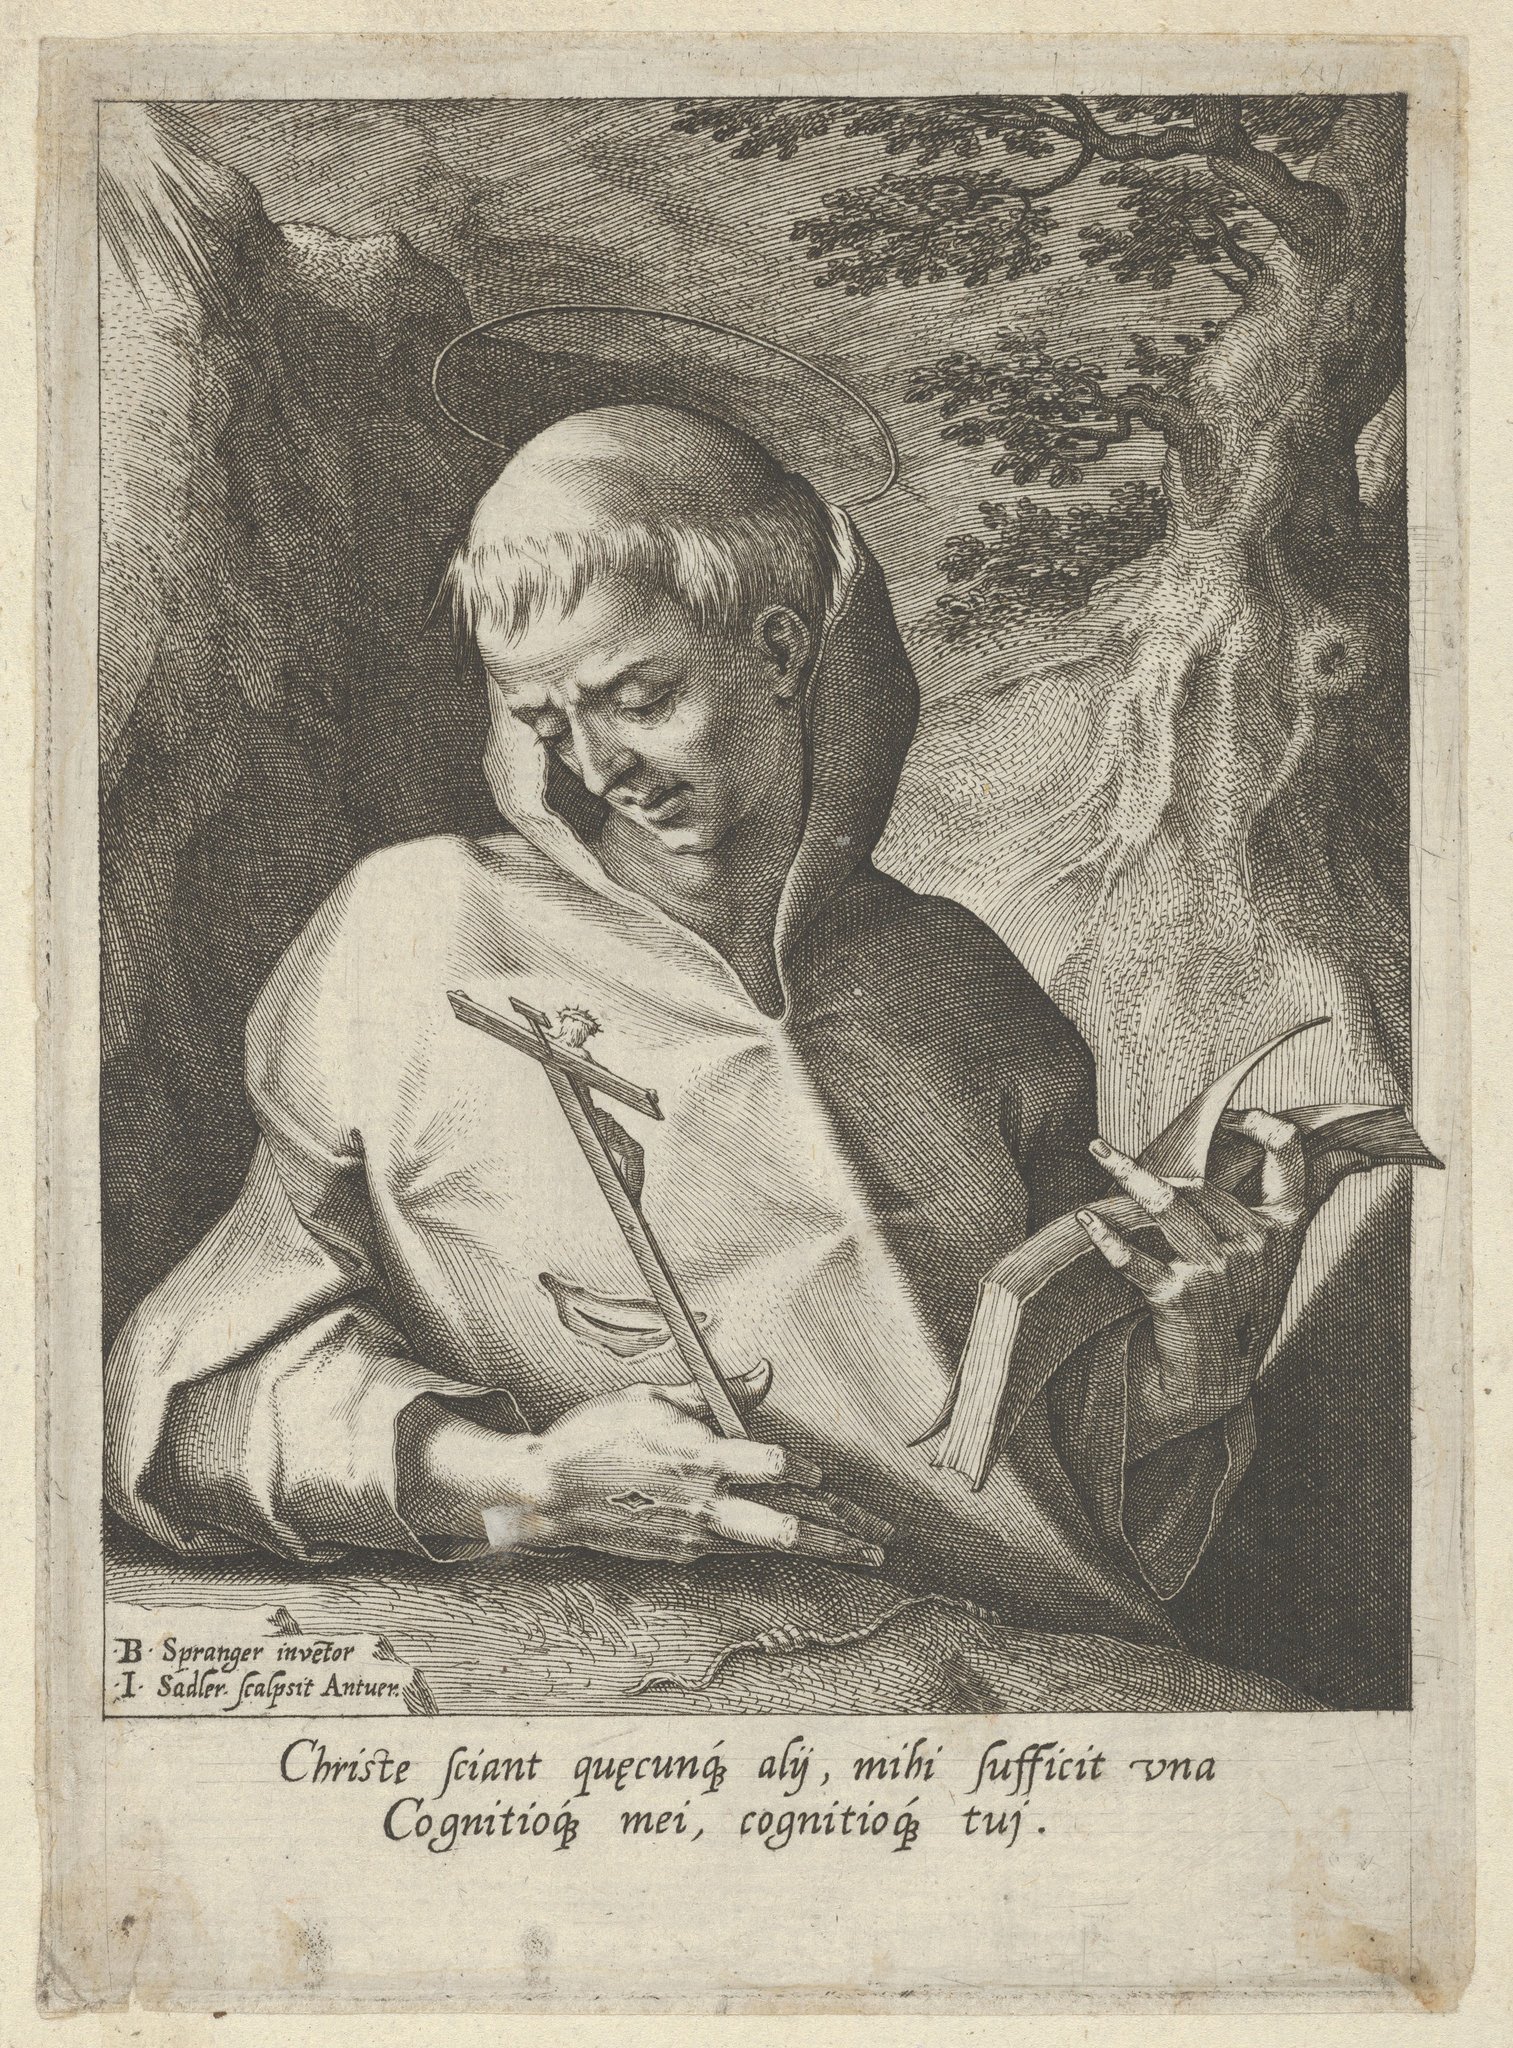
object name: print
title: Saint Francis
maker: johann sadeler (i)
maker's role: artist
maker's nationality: netherlandish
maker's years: 1550-1601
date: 1582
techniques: engraving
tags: saint francis,cross